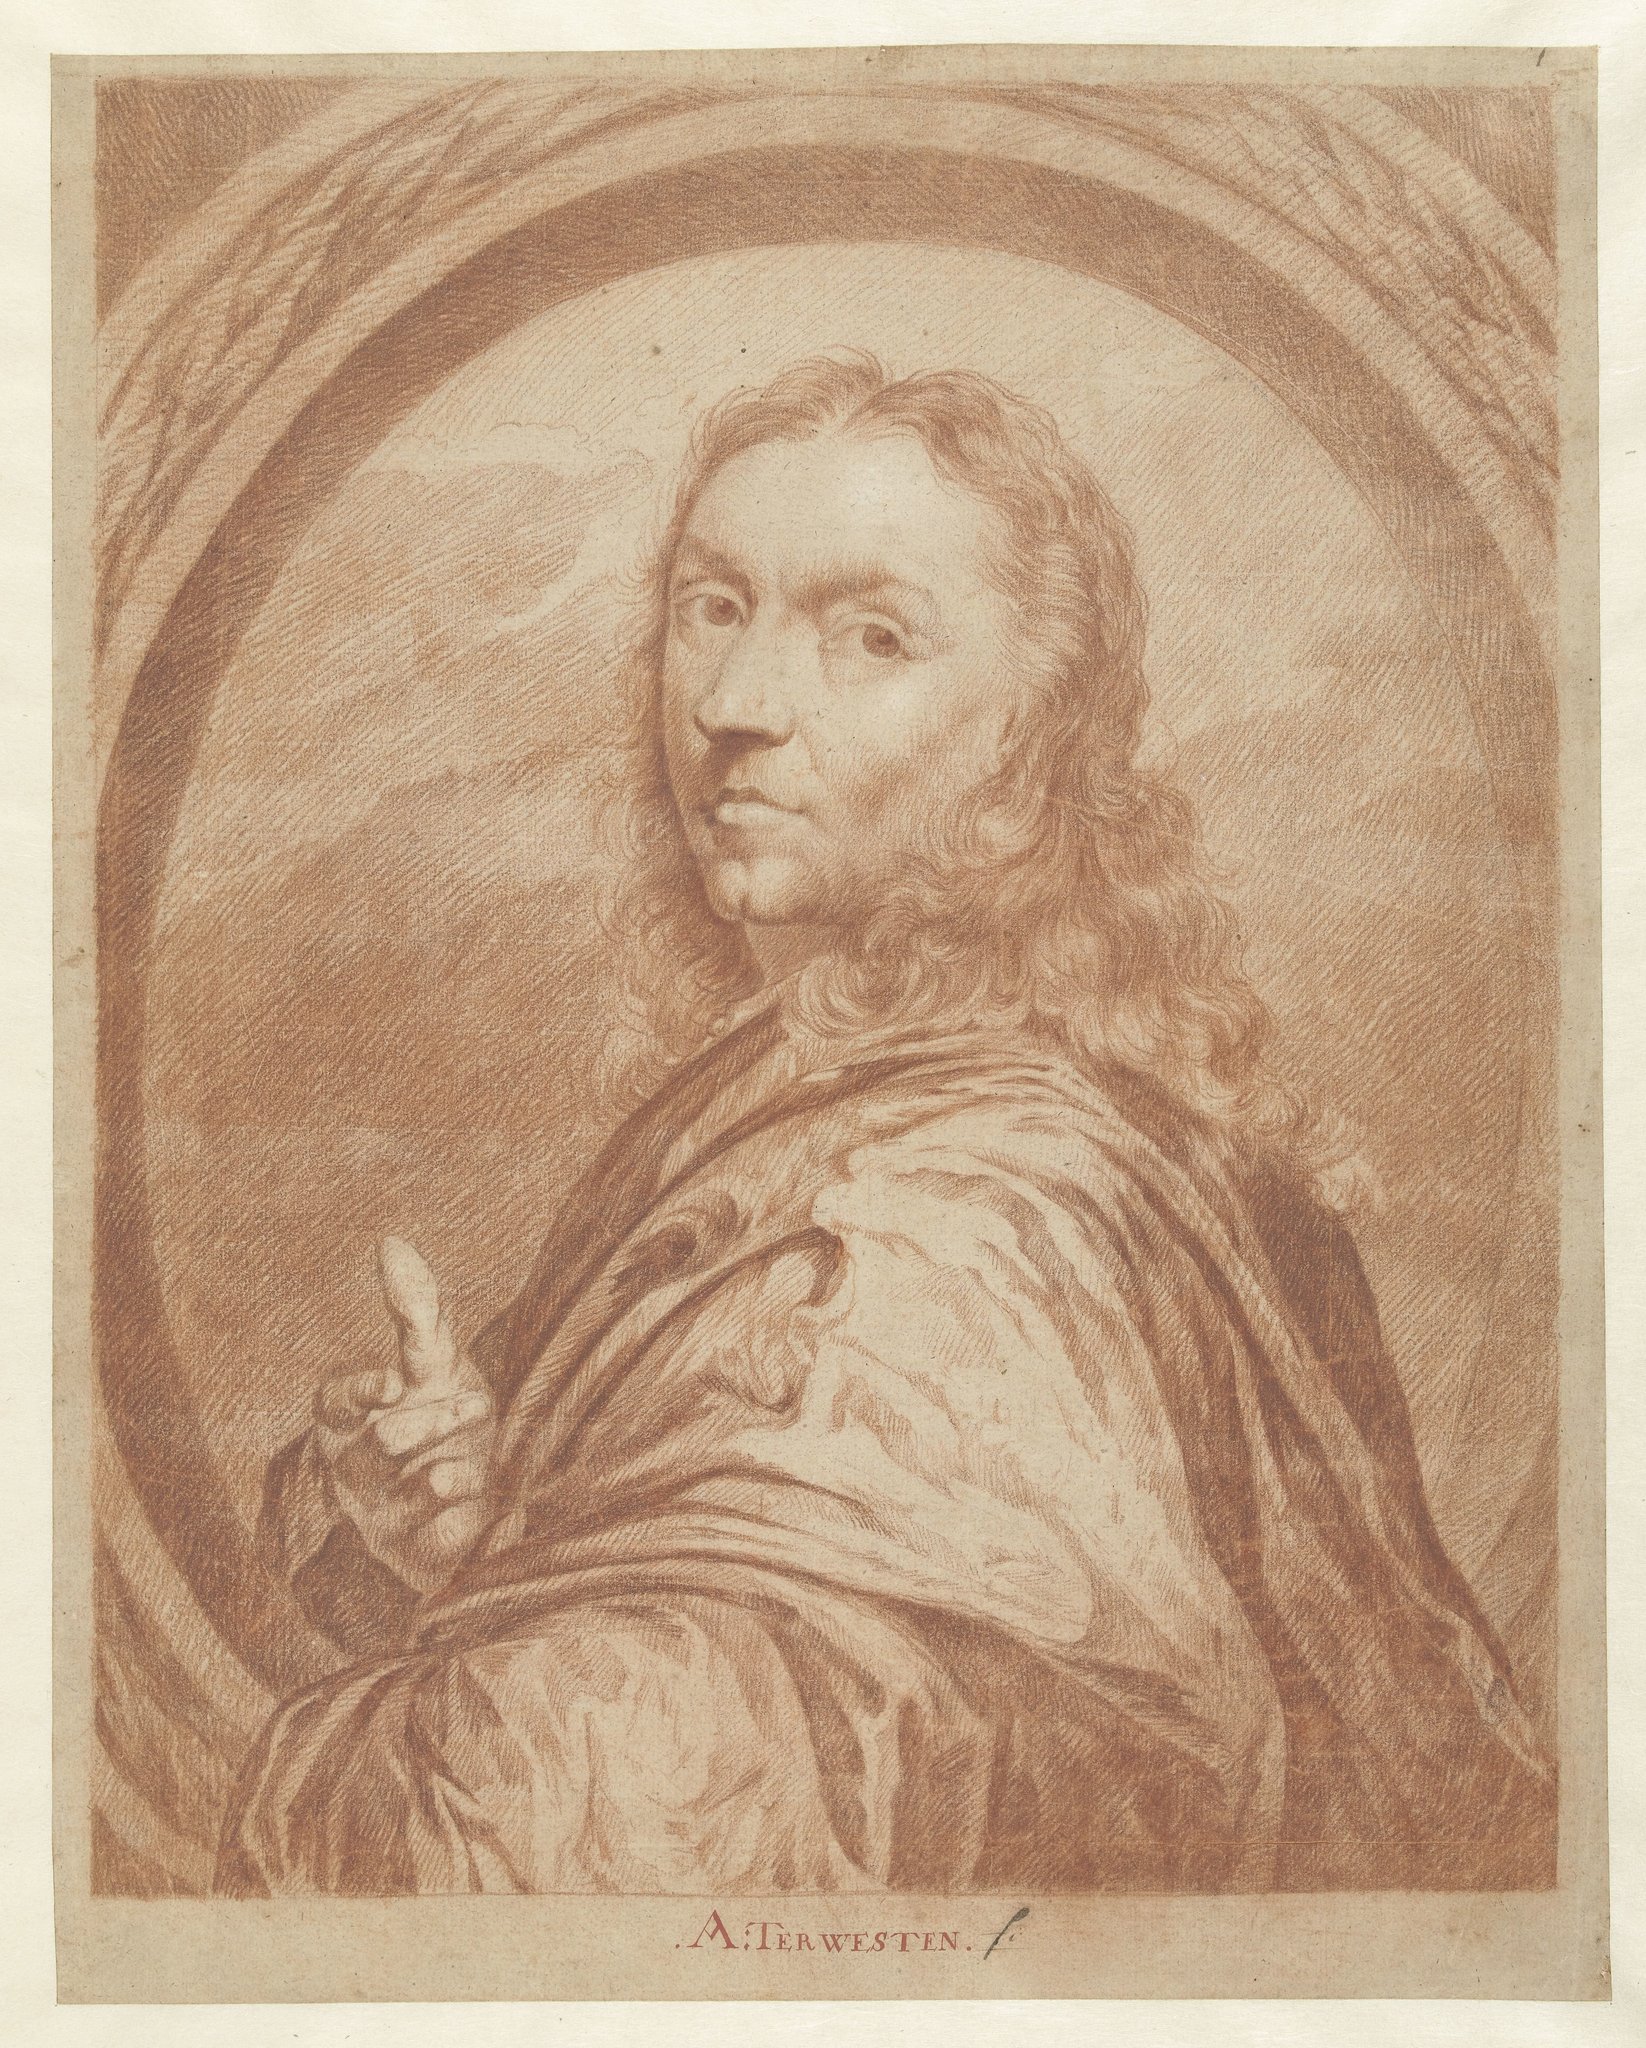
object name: drawing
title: Borstbeeld van een man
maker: augustinus terwesten (i)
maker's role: draughtsman, painter, print maker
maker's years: 1649-1711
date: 1659-1711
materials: chalk, paper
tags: anonymous historical person portrayed alone, male sex; man